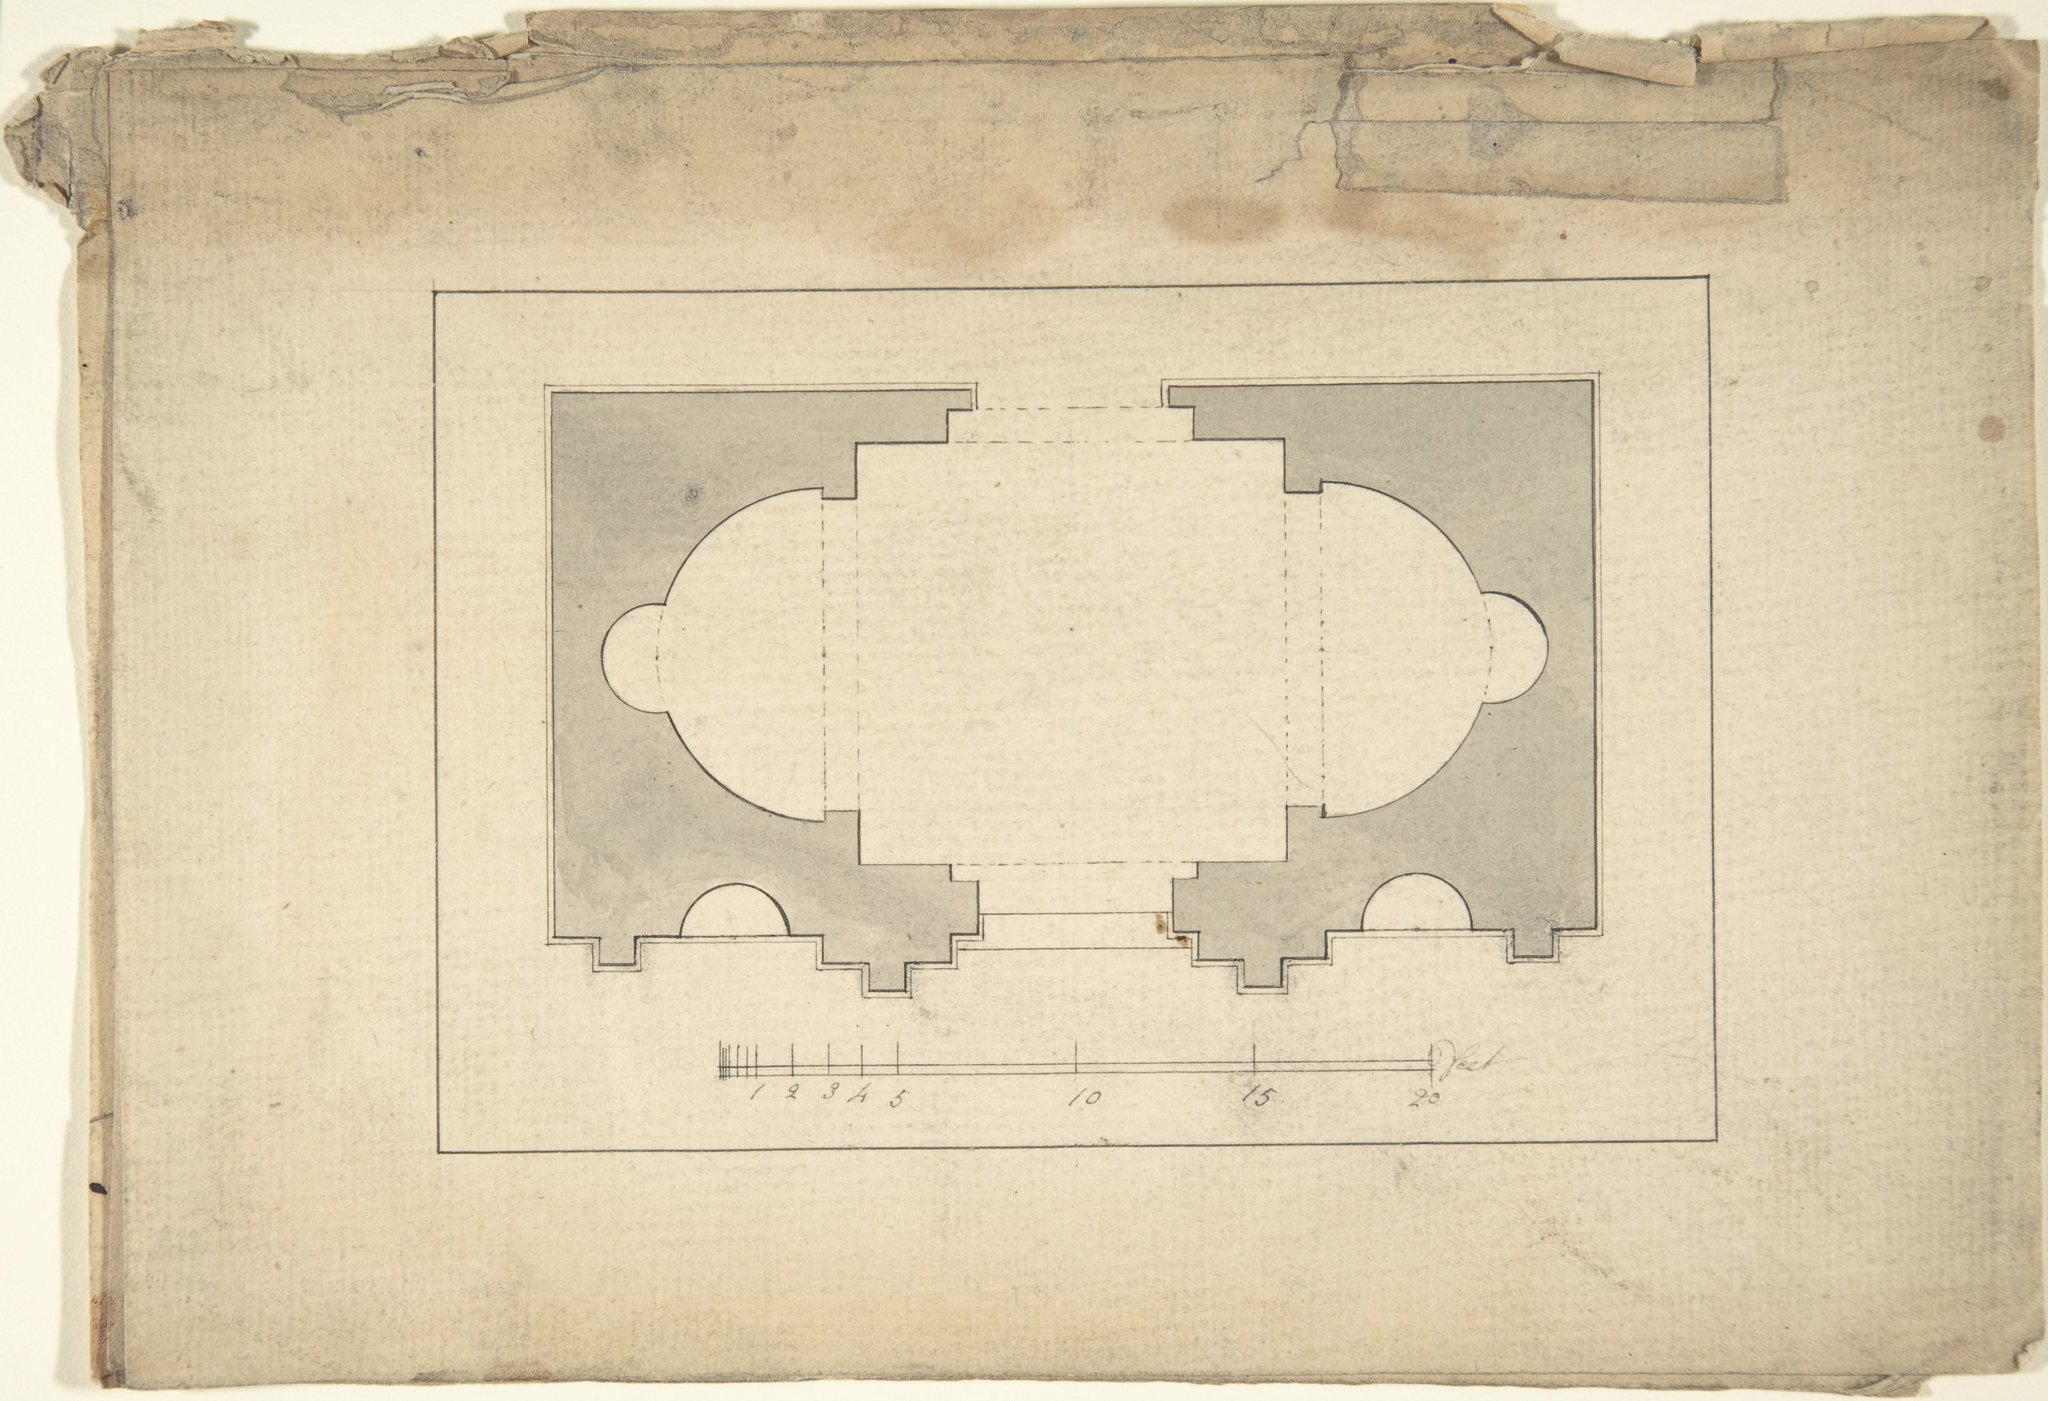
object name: drawing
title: Plan for Garden Pavilion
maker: robert morris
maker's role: artist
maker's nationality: british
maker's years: 1701-1754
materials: ink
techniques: brush, pen, wash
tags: architecture